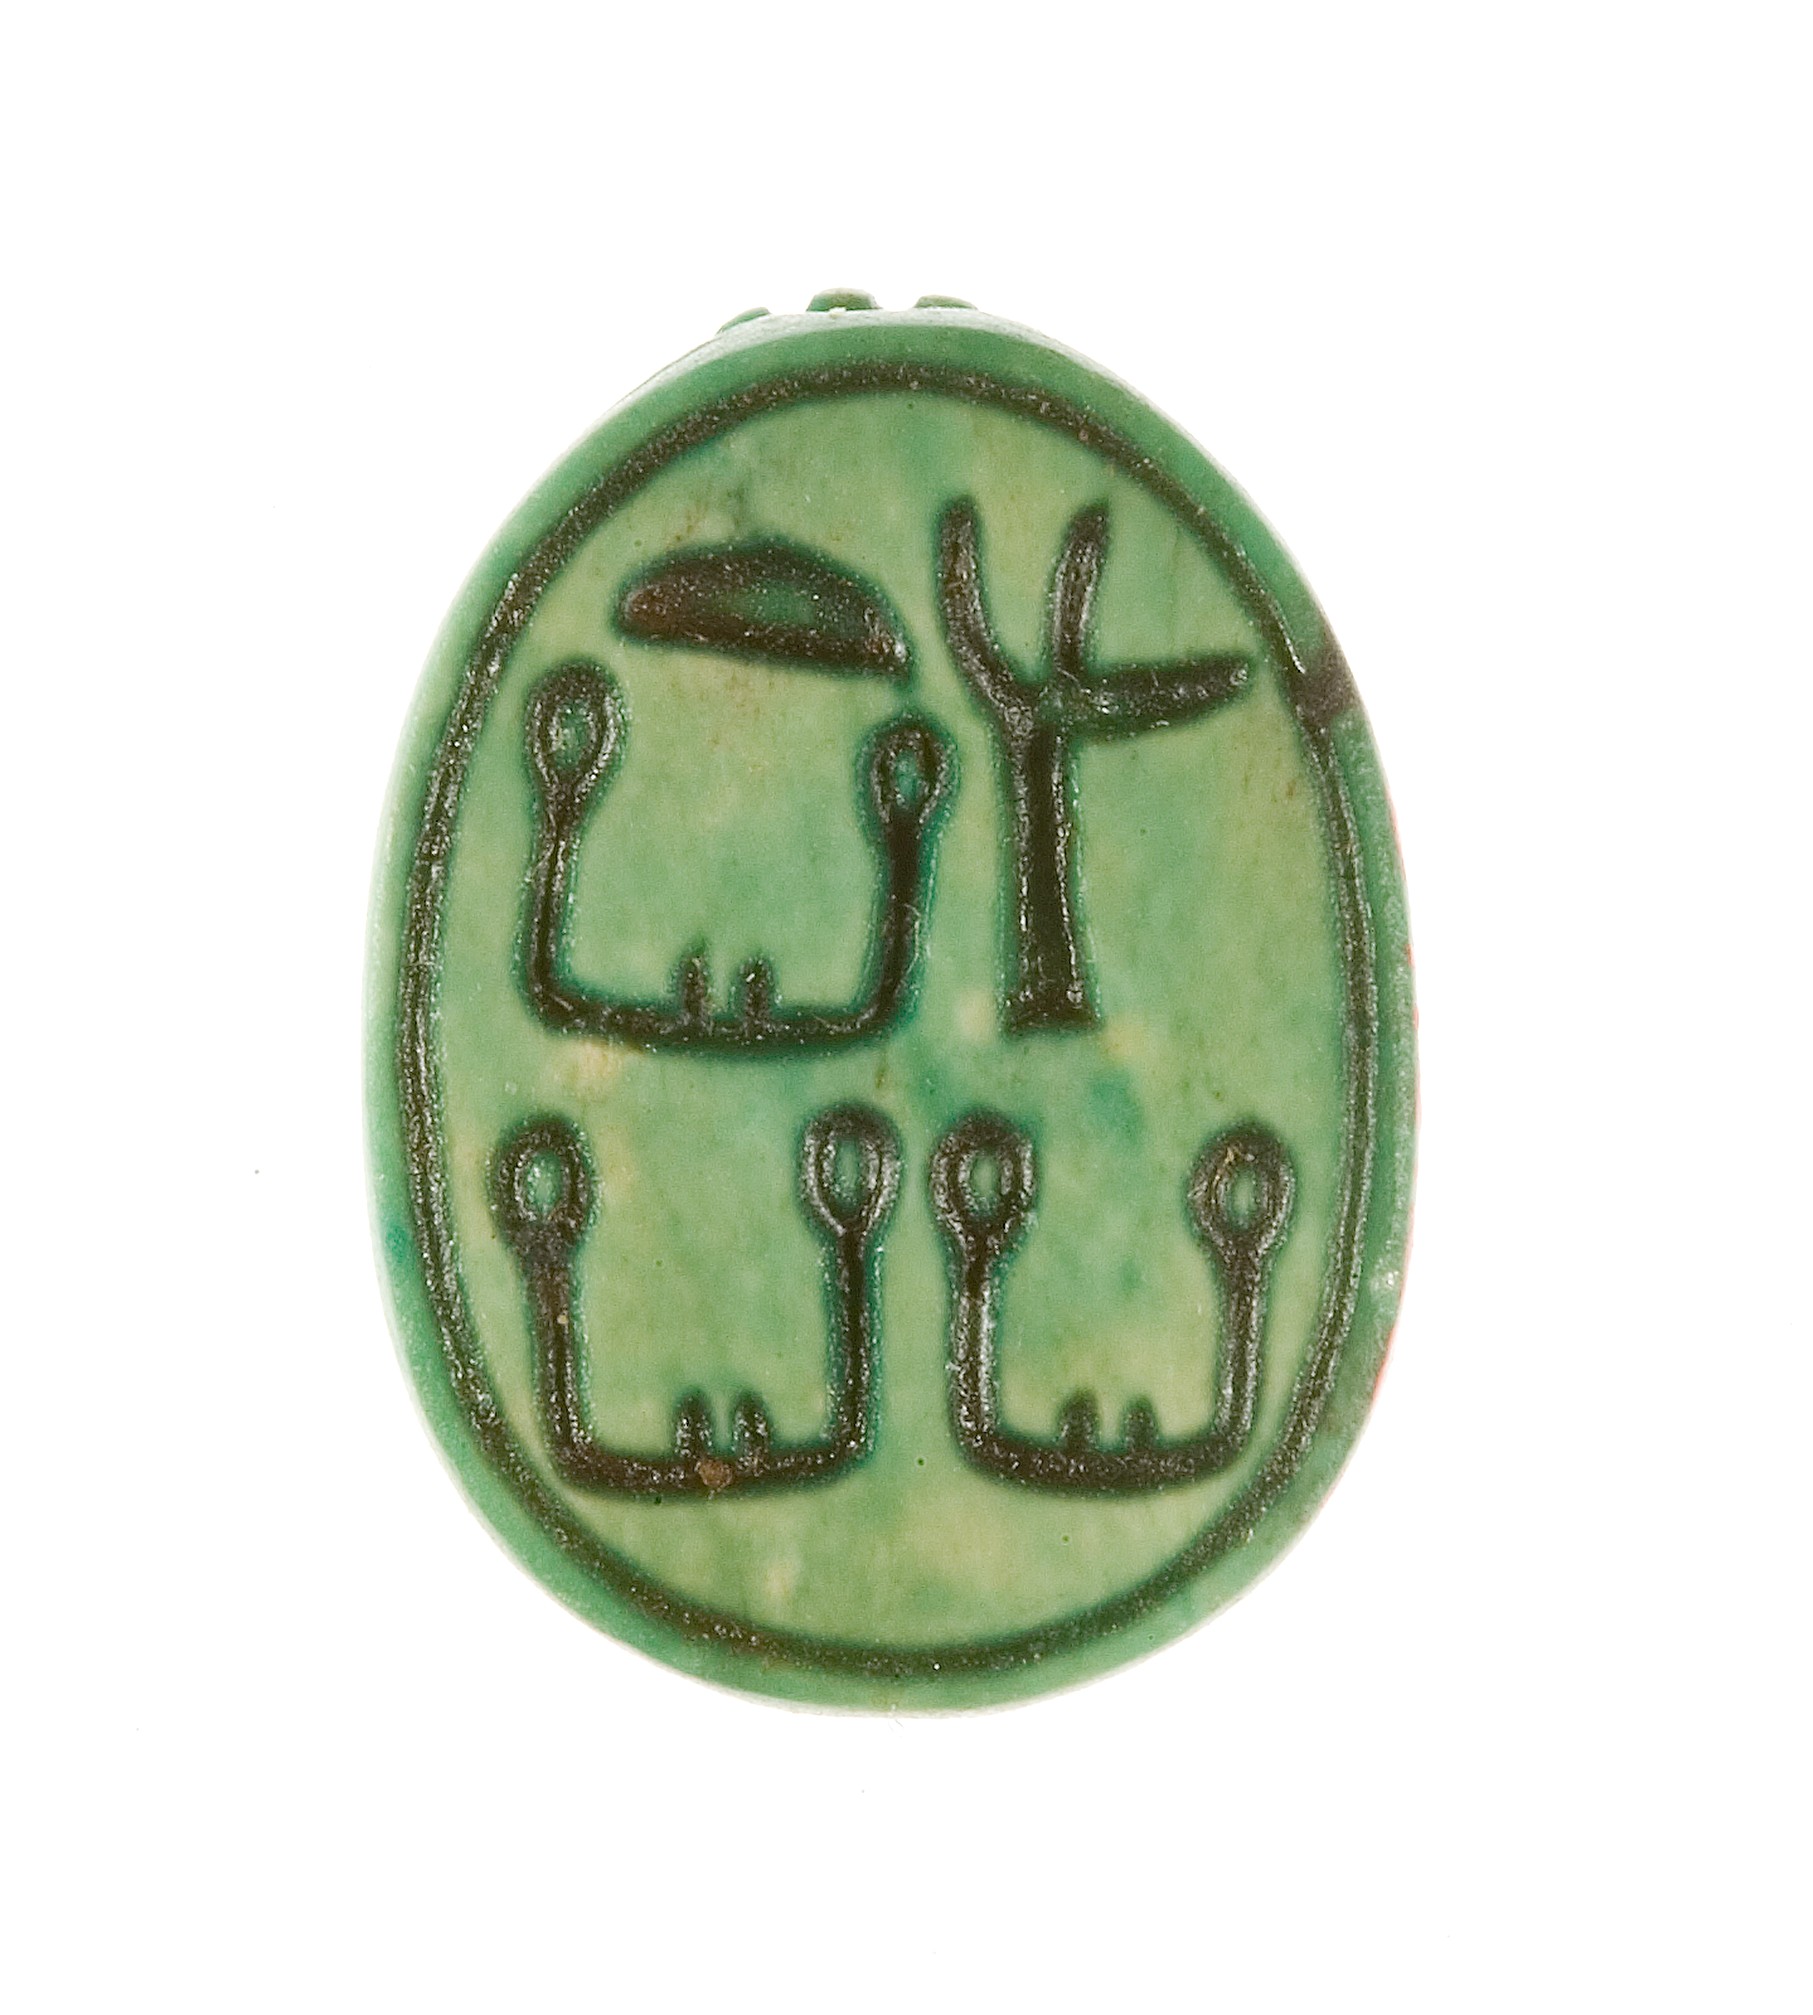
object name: scarab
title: Scarab Inscribed Wosretkau (Hatshepsut)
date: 1479-1458 BCE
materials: stone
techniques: glazing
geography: egypt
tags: hieroglyphs,scarabs